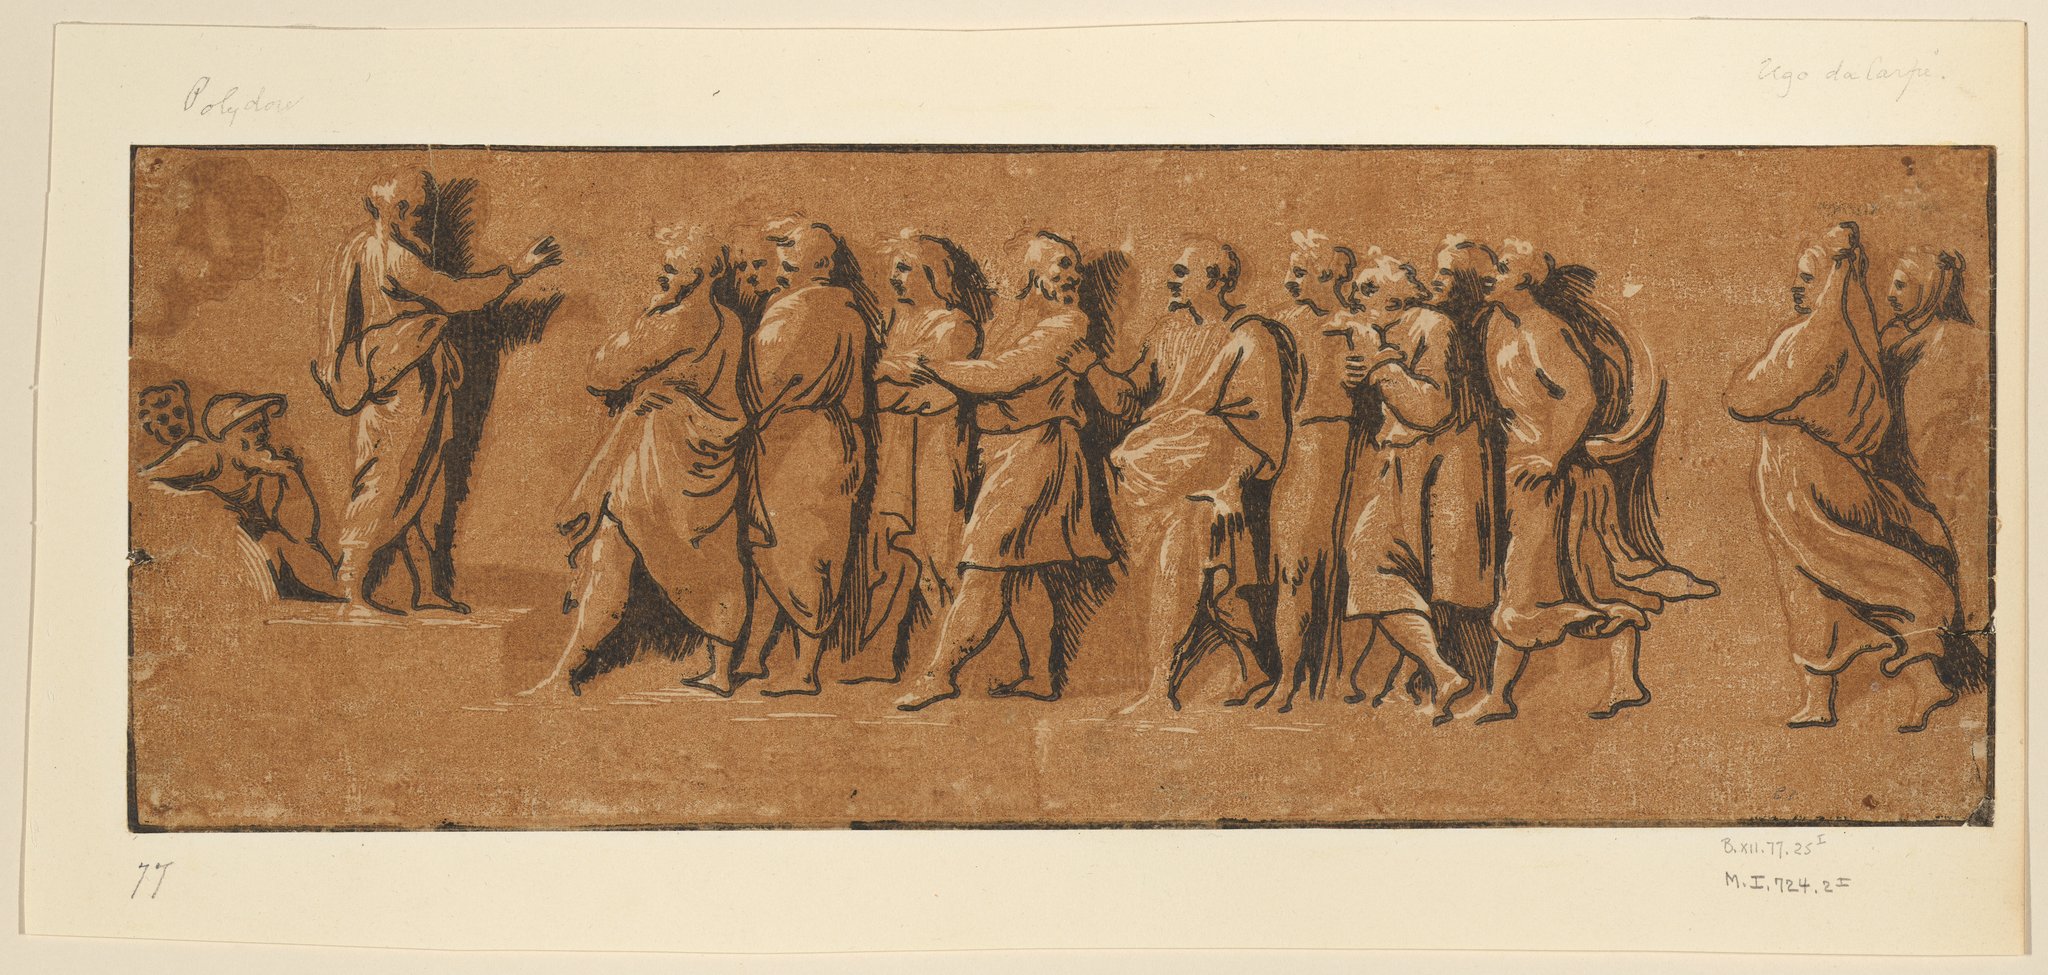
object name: print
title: Joshua addressing the people at Schechem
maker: niccolò vicentino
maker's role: artist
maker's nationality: italian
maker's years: 1510-1550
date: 1520-1550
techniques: woodcut